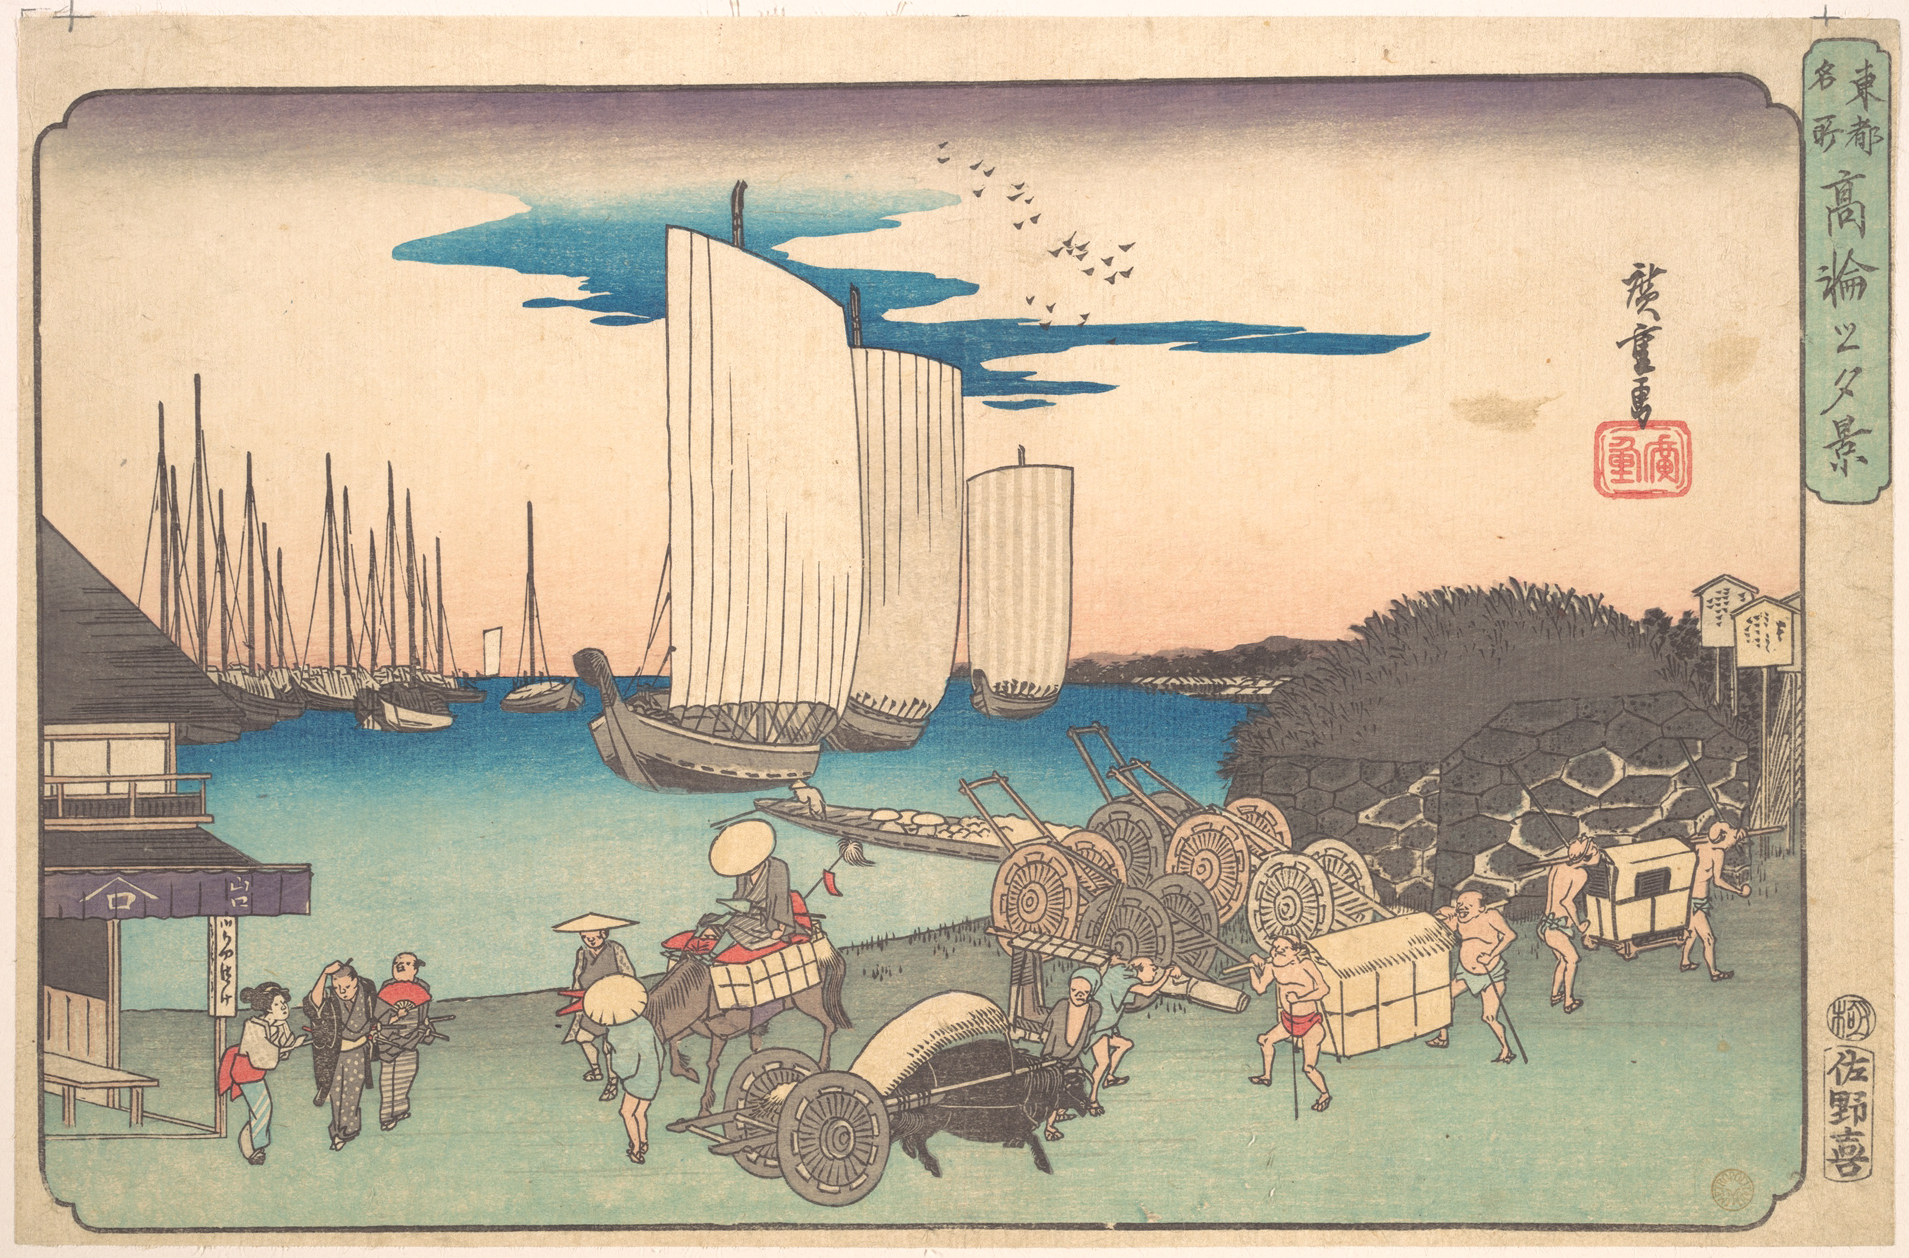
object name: print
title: Takanawa no Yukei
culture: japanese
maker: utagawa hiroshige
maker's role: artist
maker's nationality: japanese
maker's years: 1797-1858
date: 1833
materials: ink, paper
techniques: woodblock print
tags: animals,men,women,boats